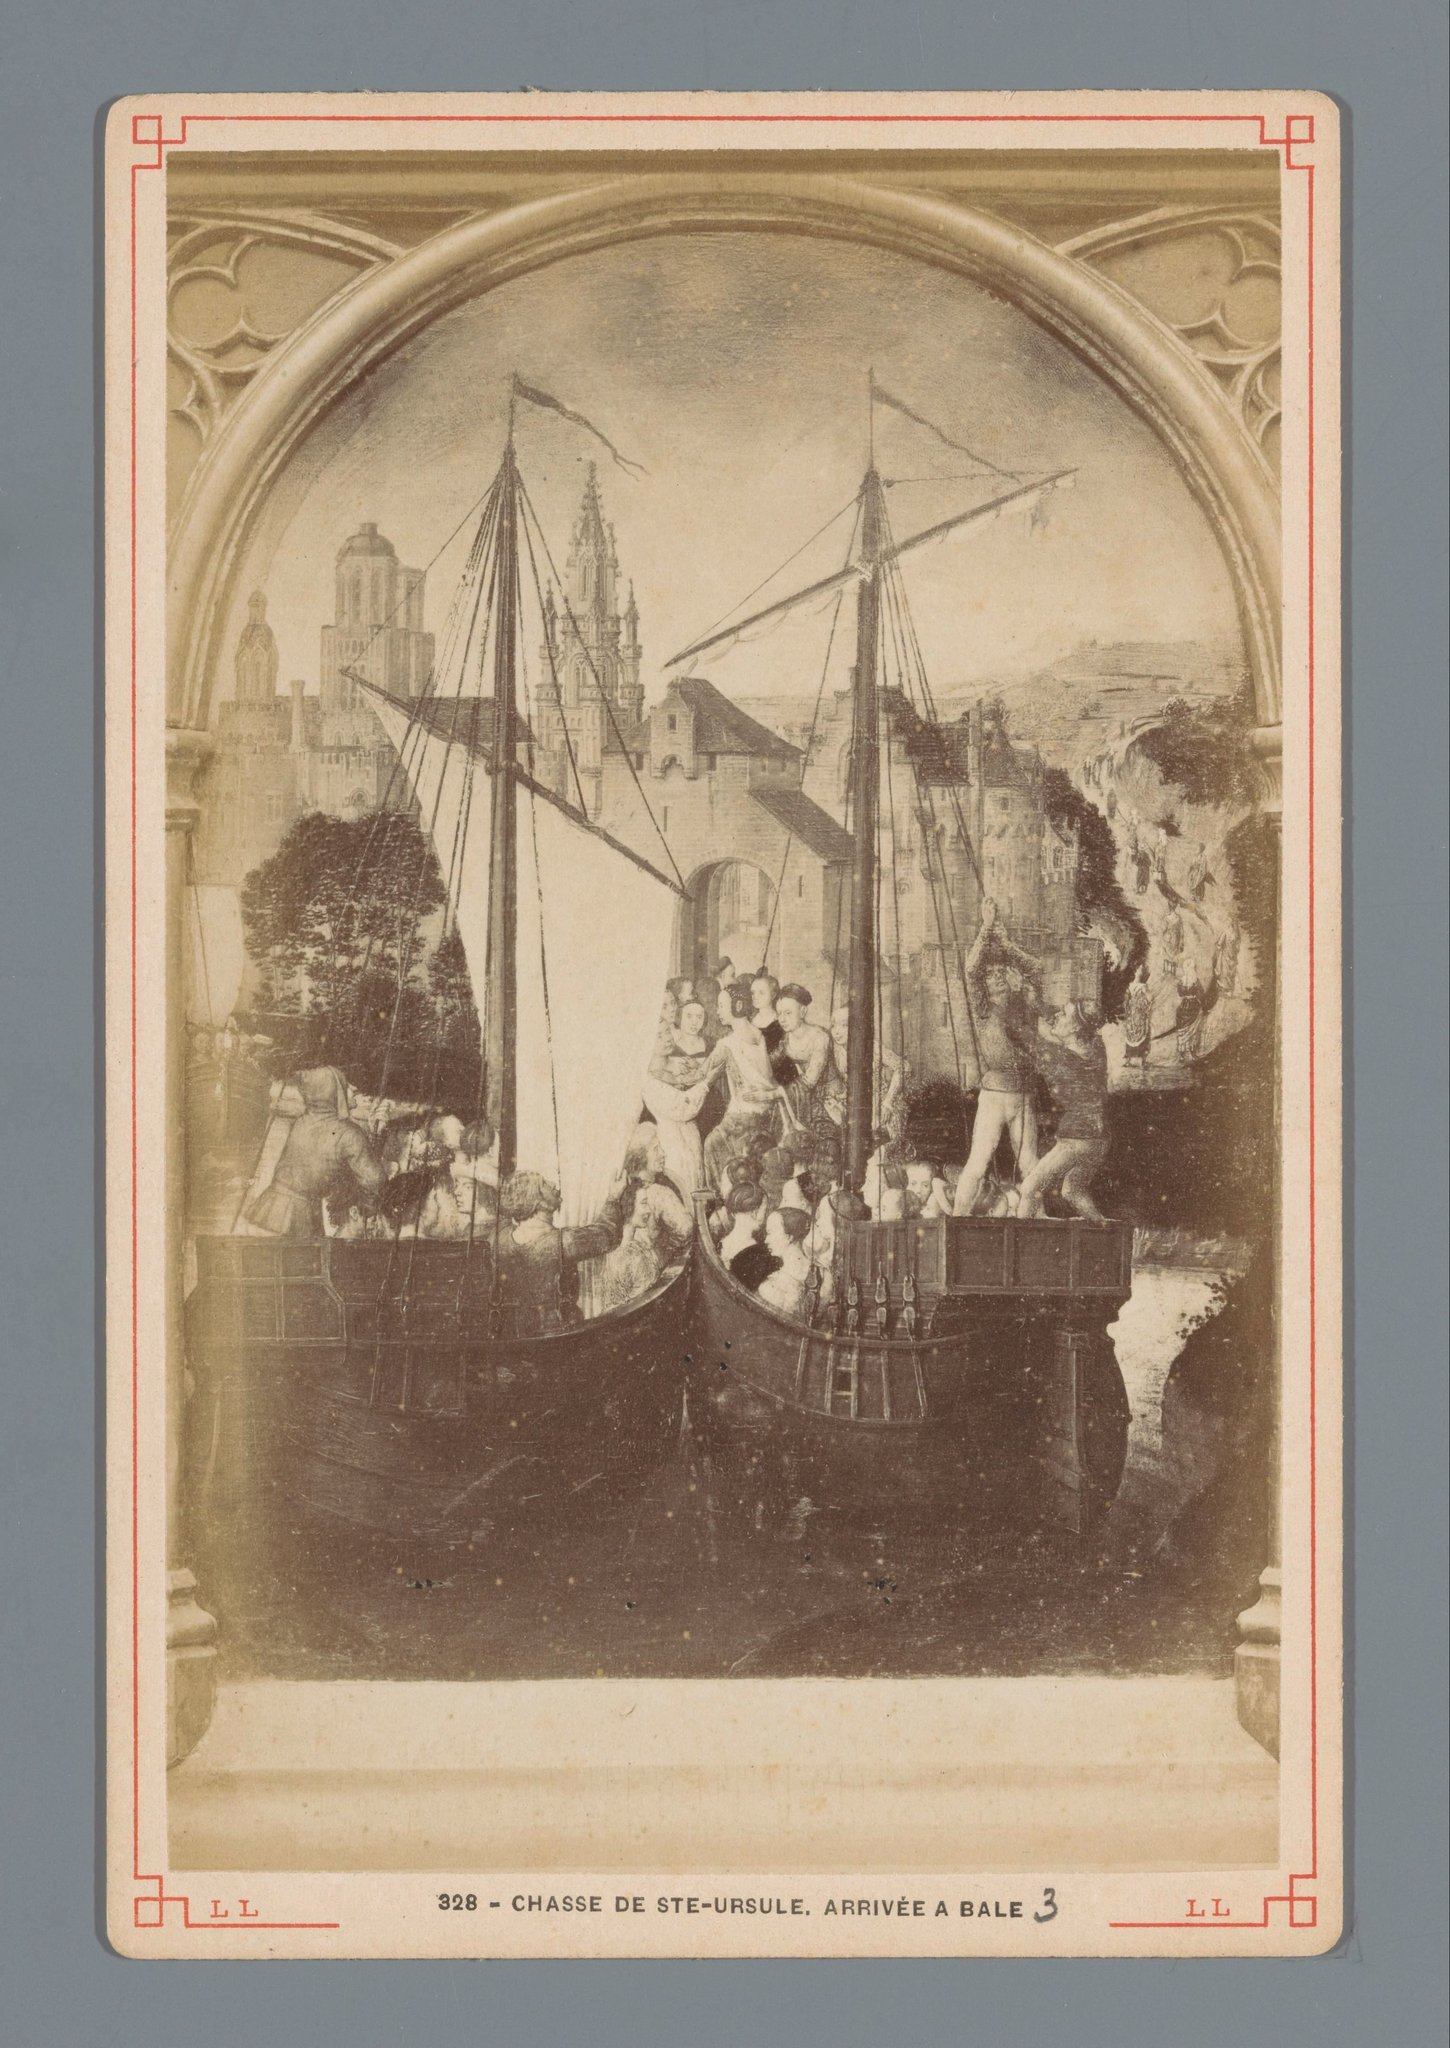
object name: cabinet photograph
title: Chasse de Ste-Ursule. Arrivée a Bale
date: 1864-1900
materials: cardboard, photographic support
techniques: albumen print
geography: sint-janshospitaal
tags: the pilgrimage of st. ursula and her companions to rome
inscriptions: number: ‘3’, number: ‘328’